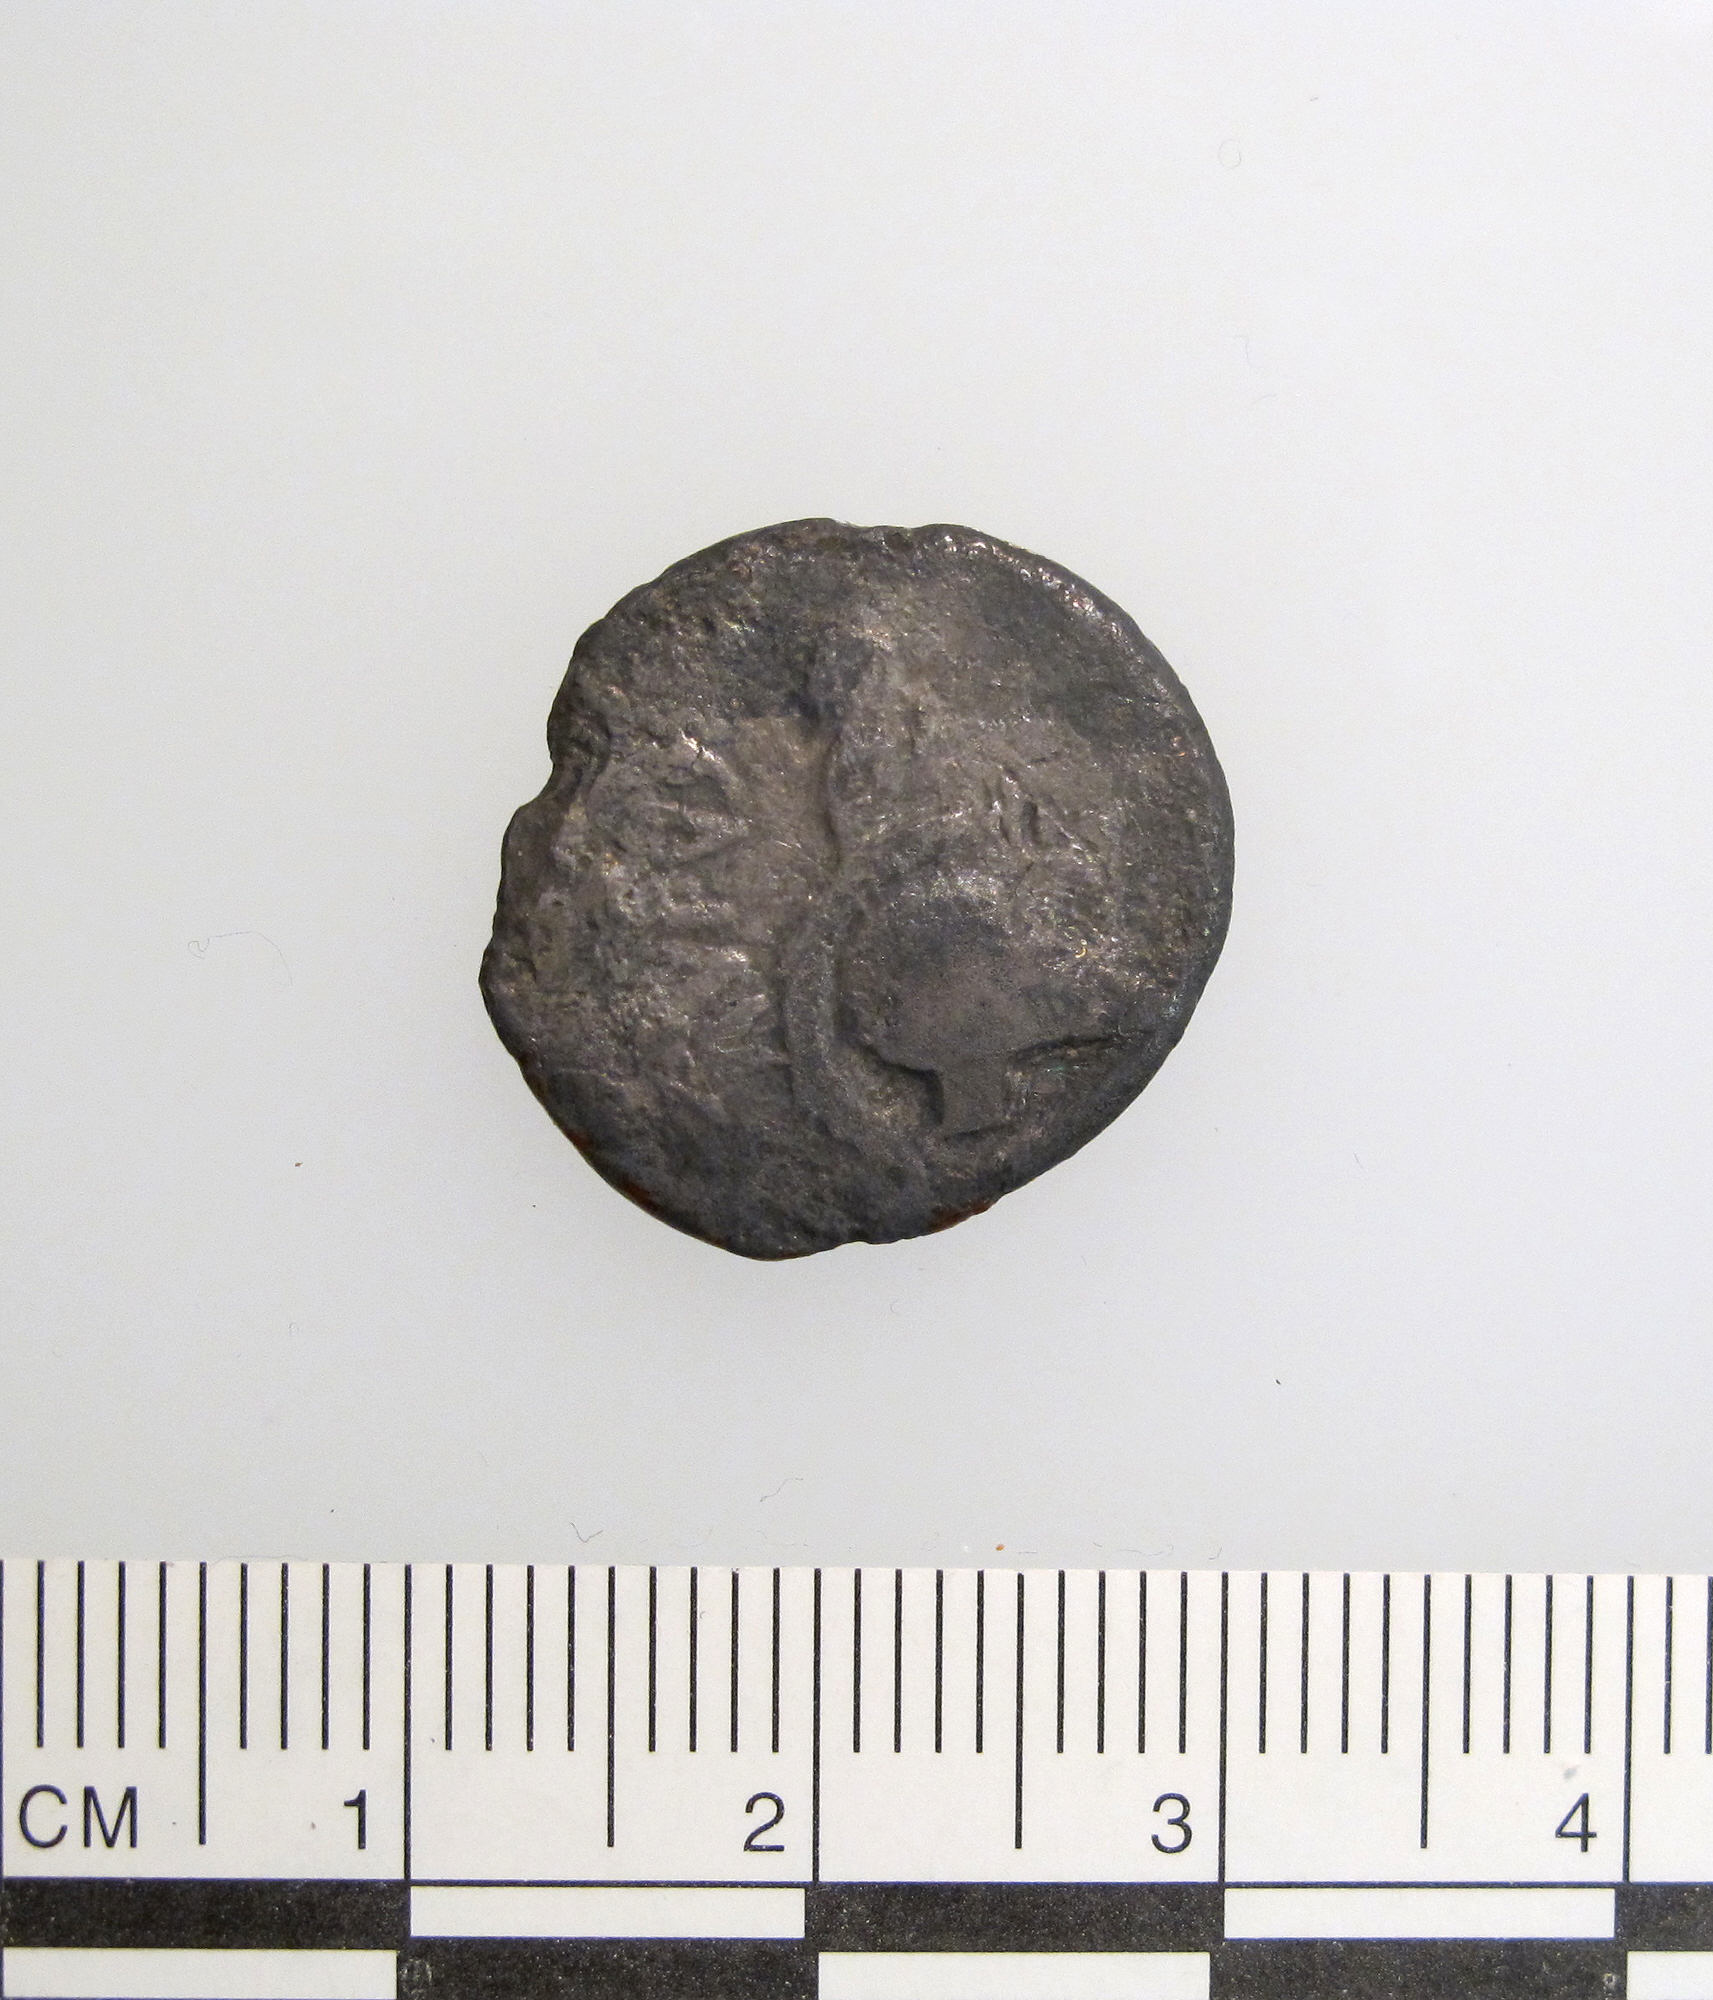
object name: denarius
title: Silver denarius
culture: roman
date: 46 BCE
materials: silver